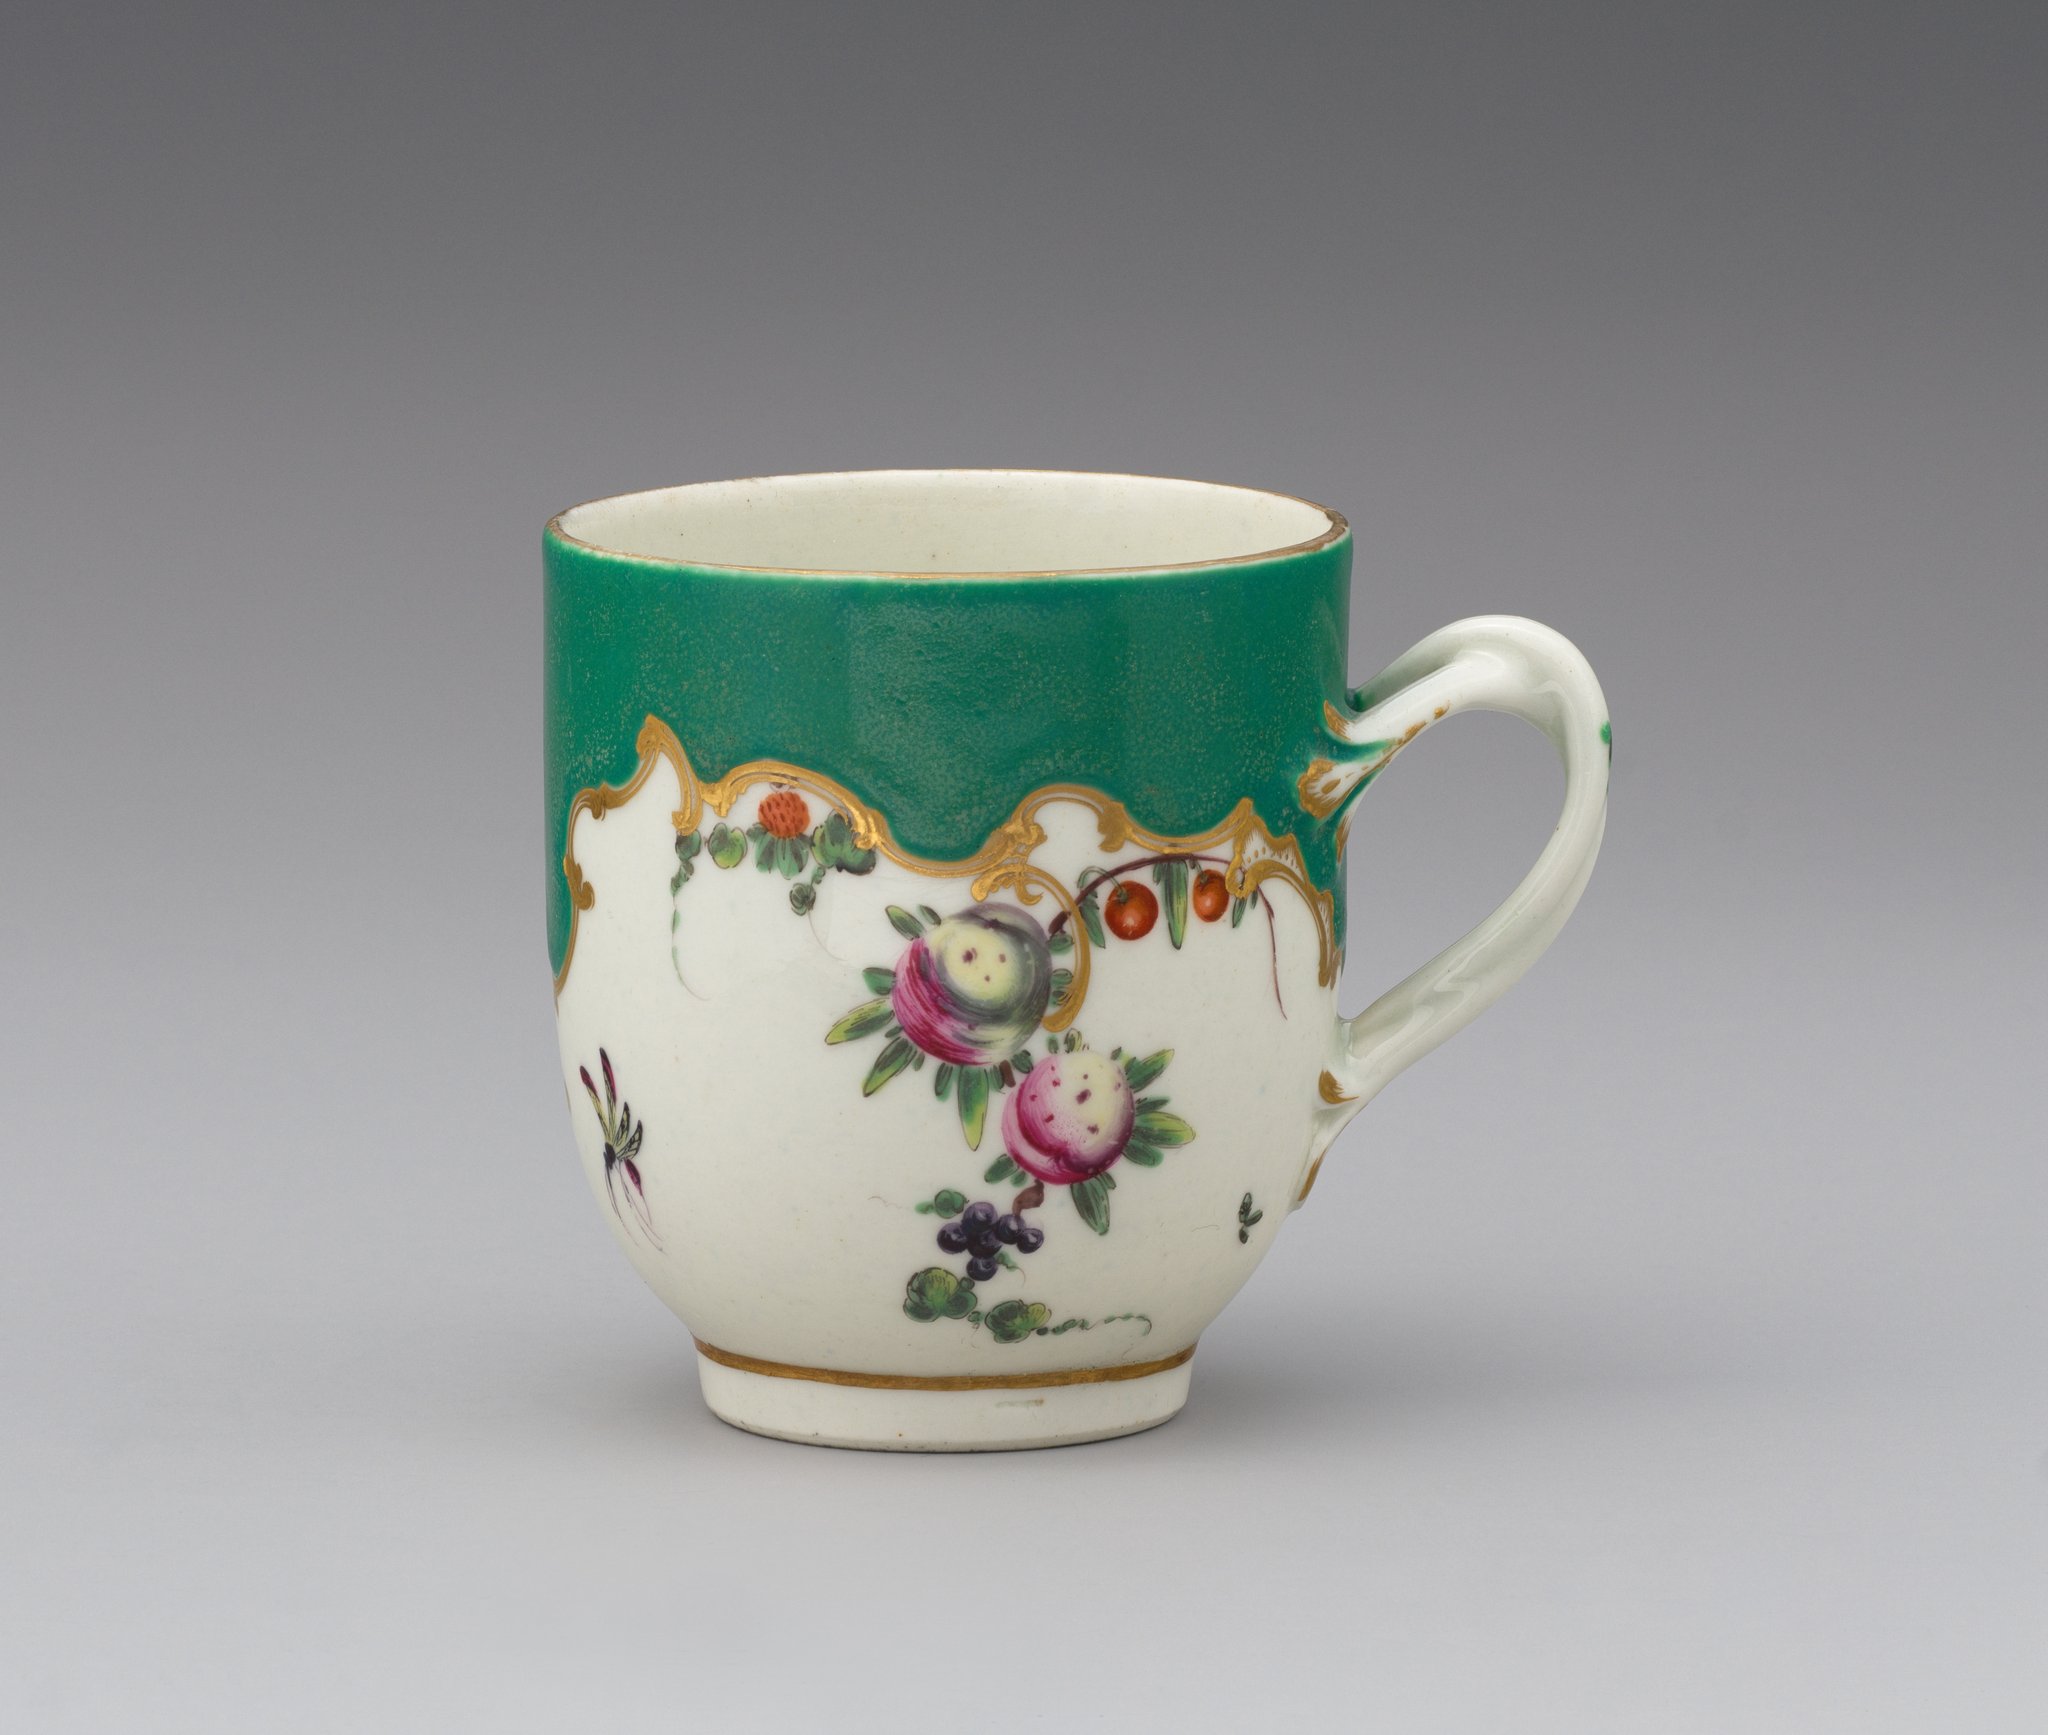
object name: cup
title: Cup (part of a service)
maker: worcester factory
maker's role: factory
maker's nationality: british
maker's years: 1751-2008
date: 1770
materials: soft paste porcelain